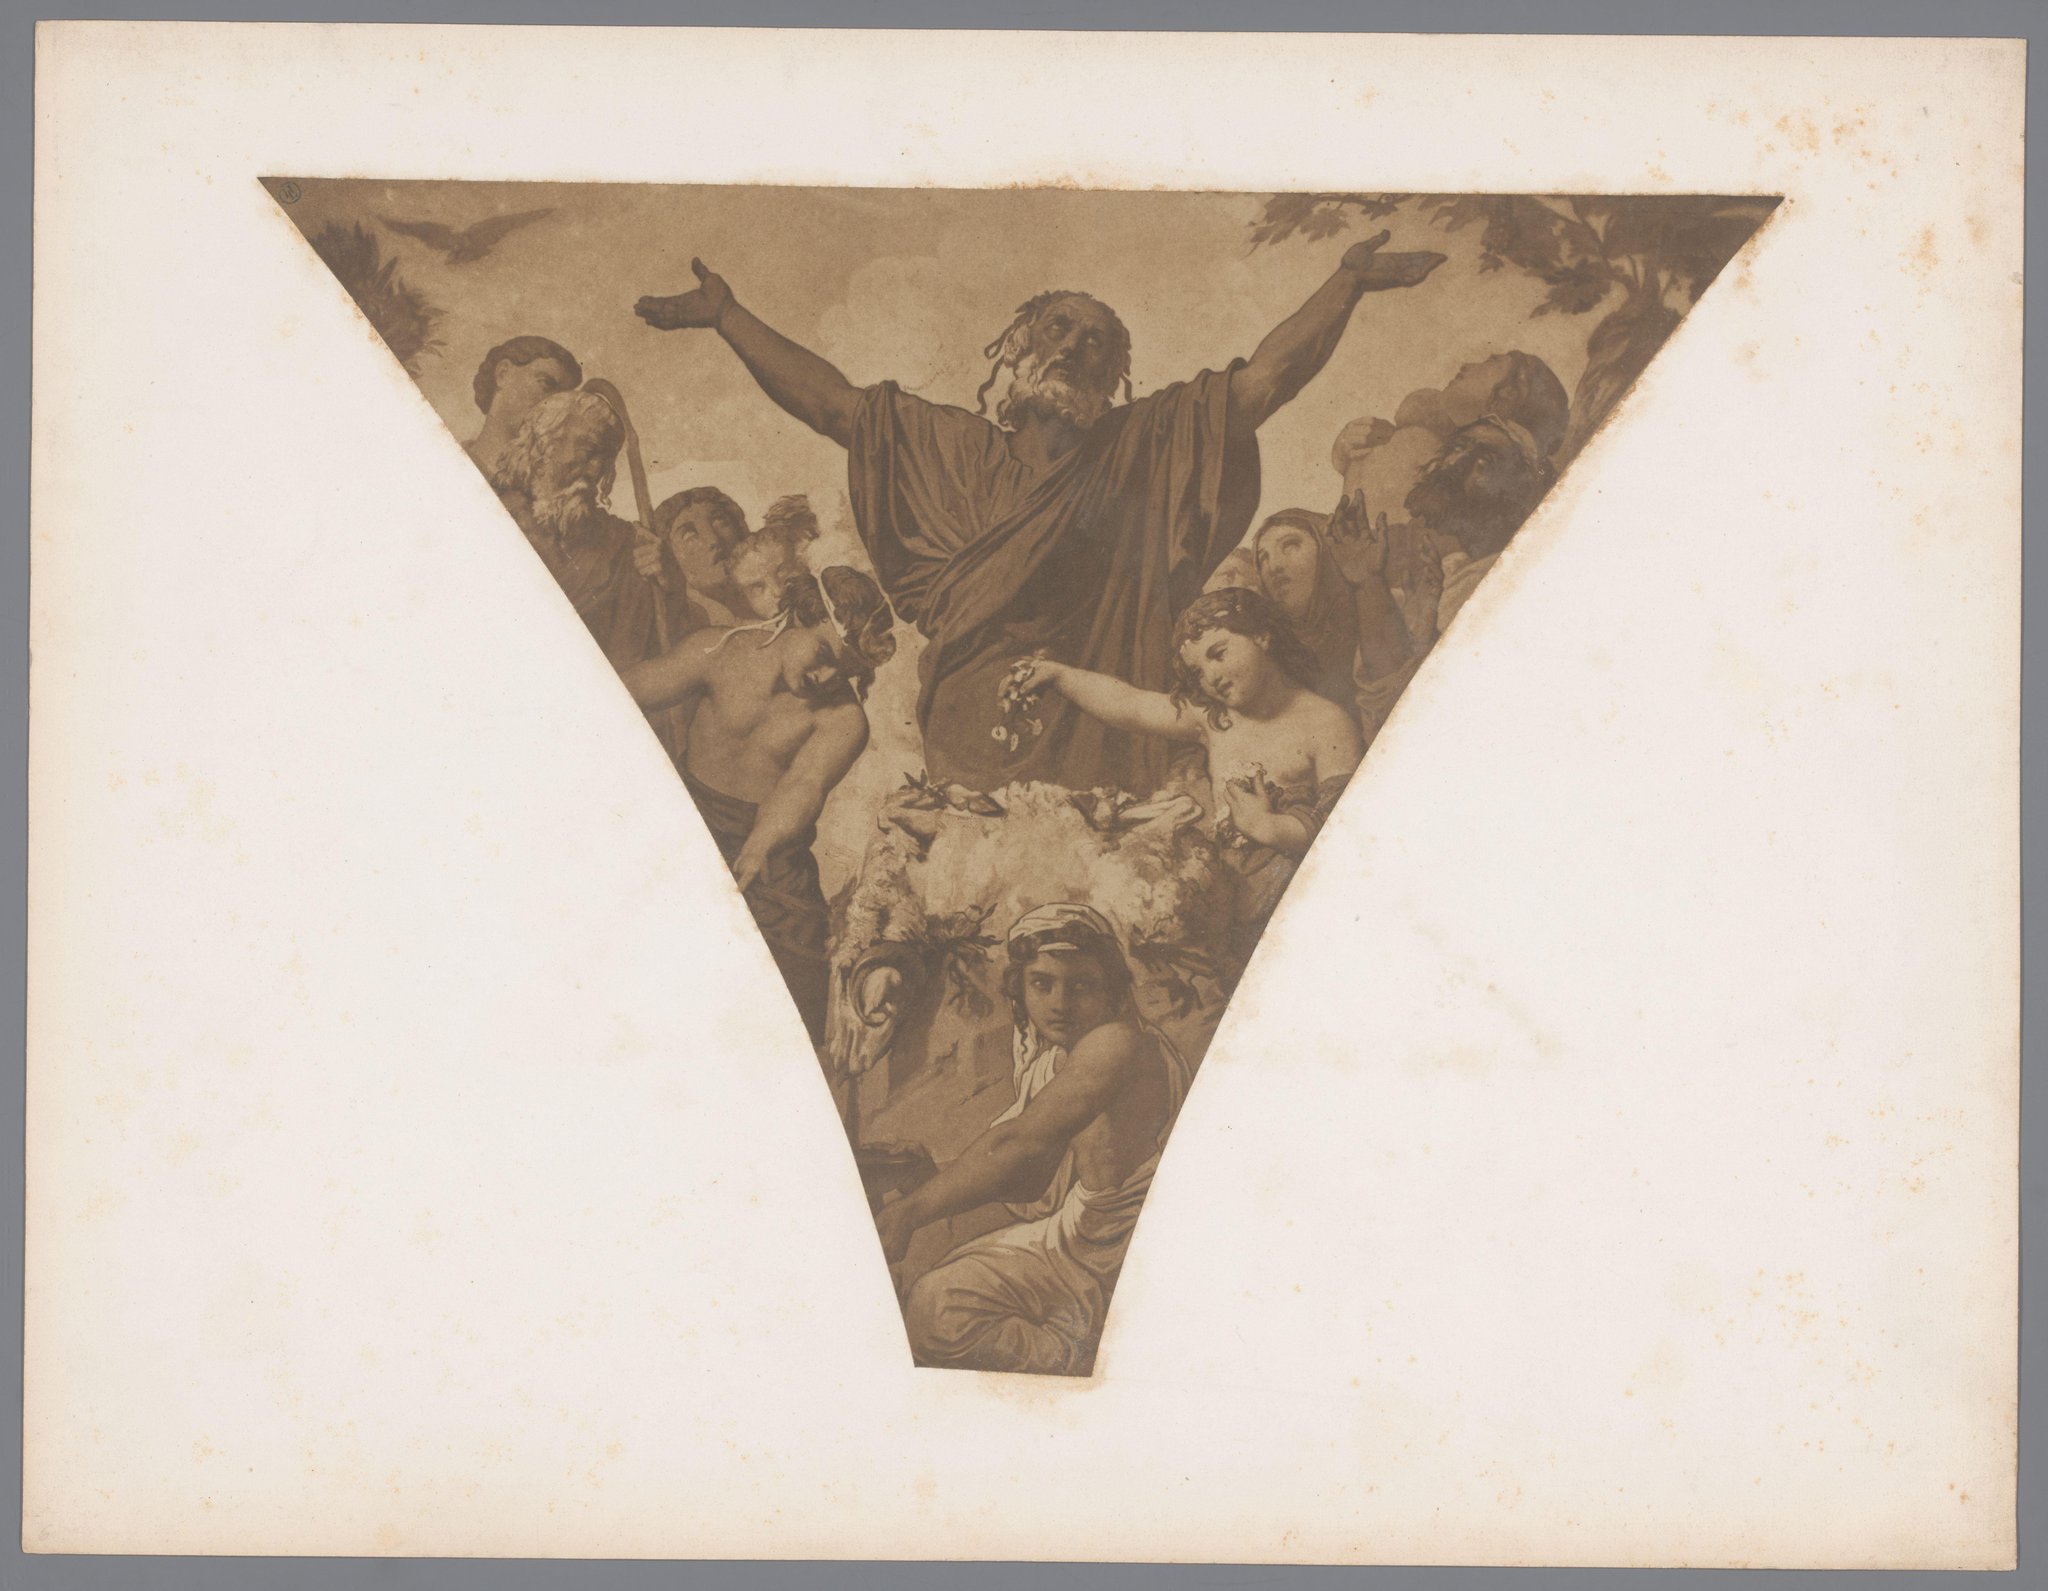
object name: photograph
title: Fotografische reproductie van decoratie aan plafond, Hotel de Ville, Parijs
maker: gustave le gray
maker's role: fotograaf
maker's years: 1820-1884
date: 1852-1853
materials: cardboard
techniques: salted paper print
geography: france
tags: paris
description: Maakt onderdeel uit van een serie van 18 bladen met foto's van de cartons voor de plafondschilderingen door Henri Lehmann voor de Galerie des Fêtes in het Hotel de Ville, Parijs.